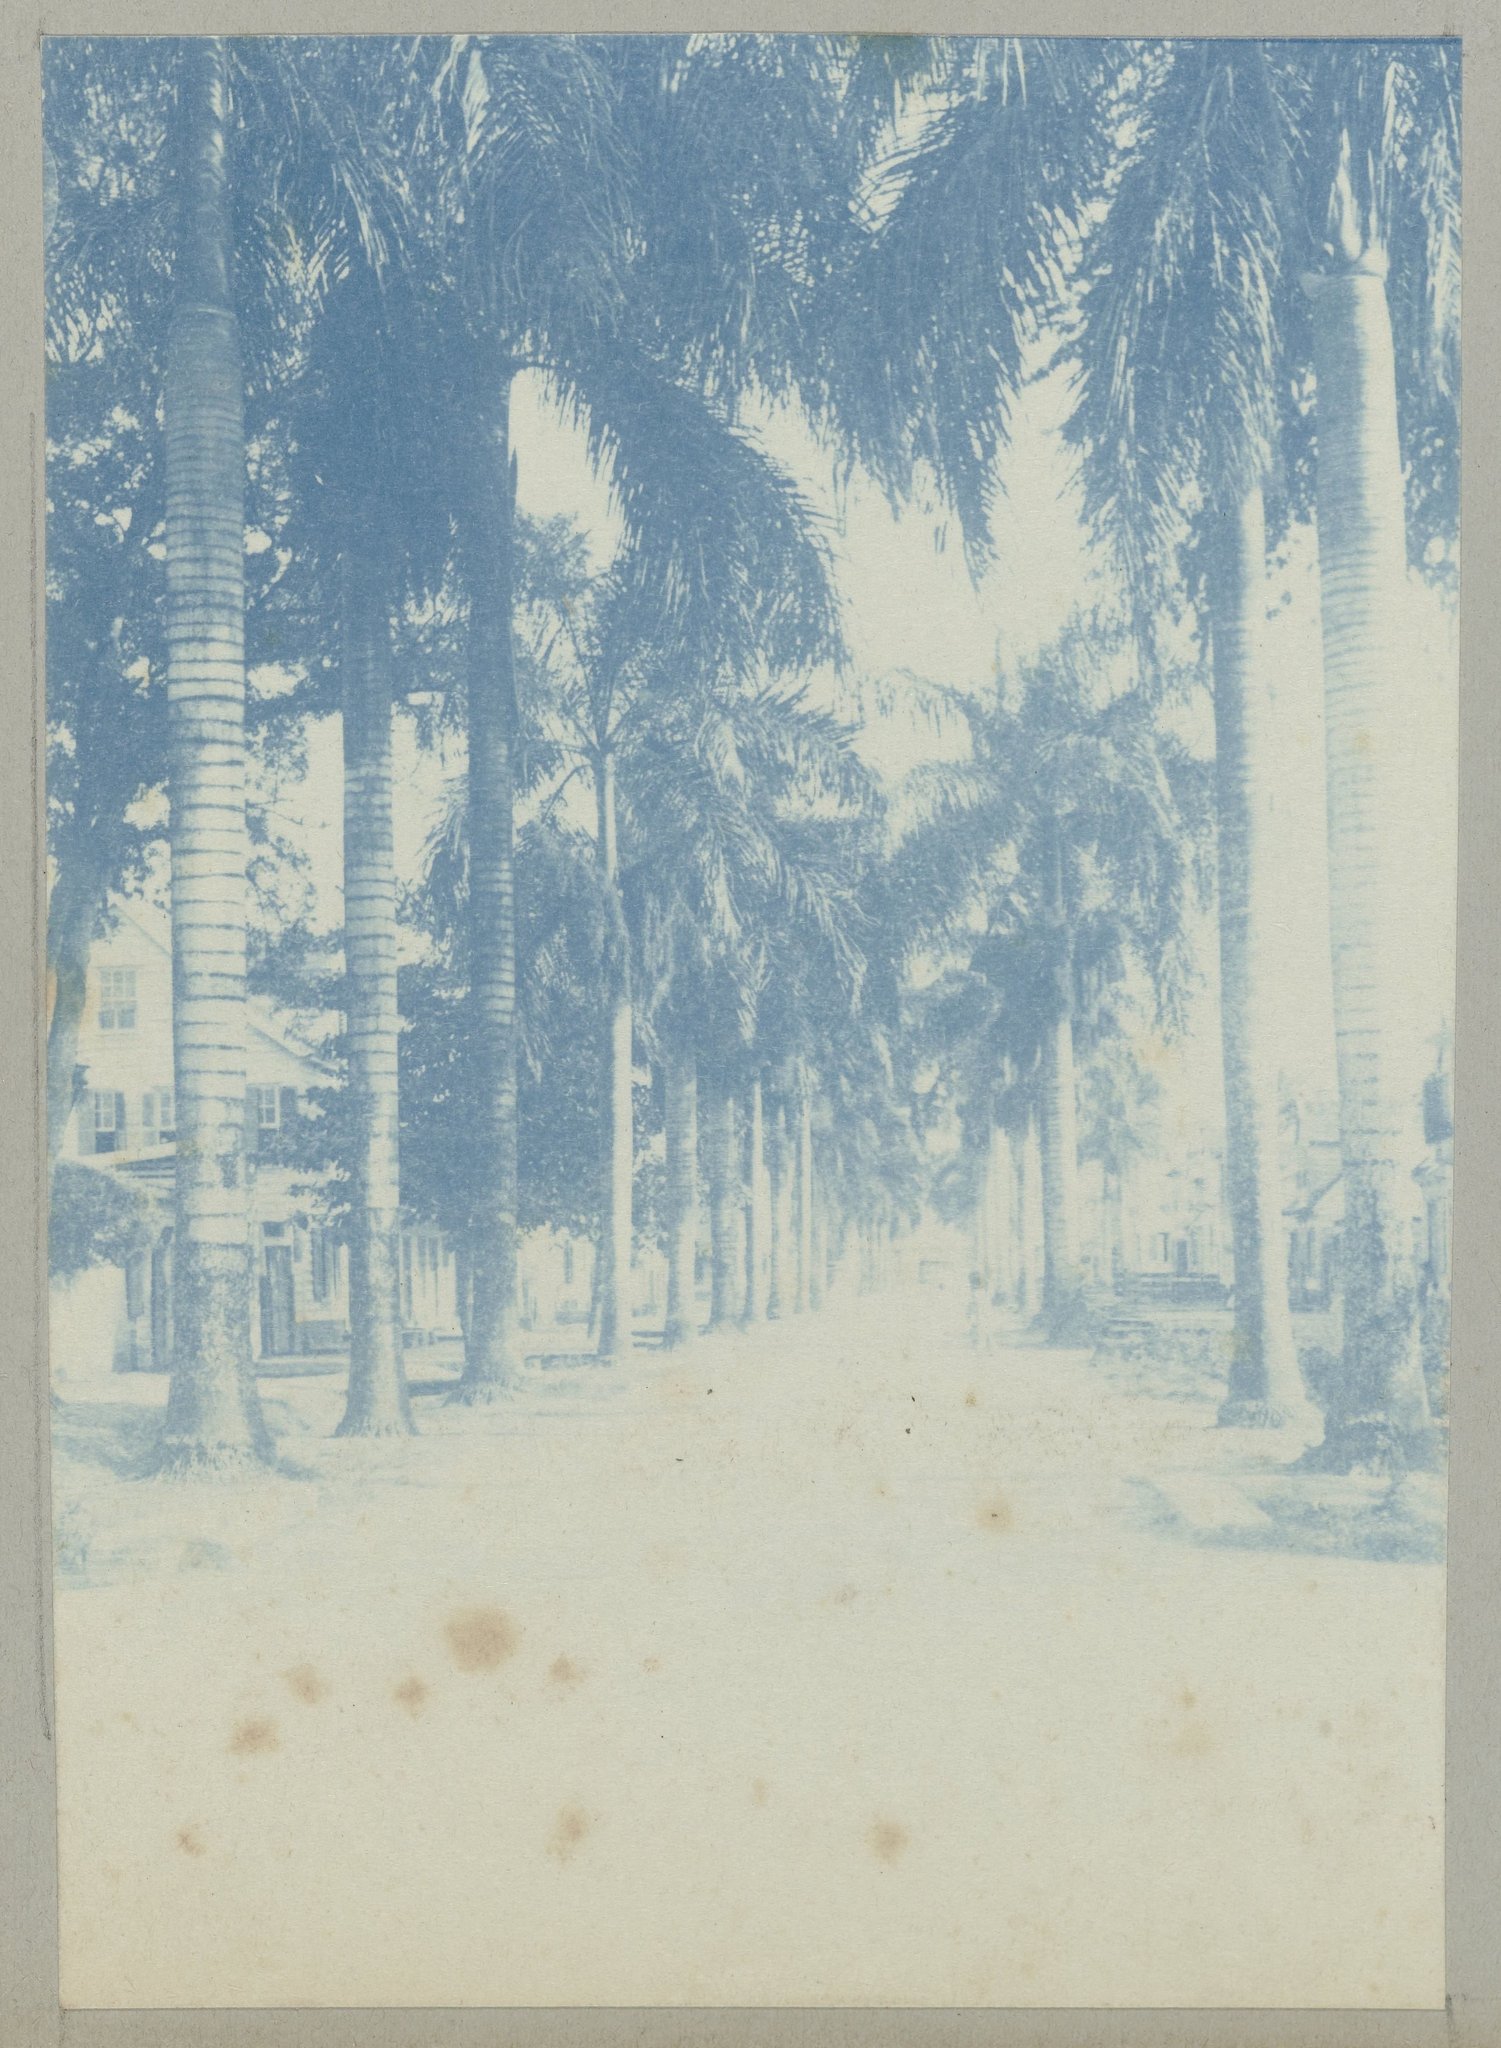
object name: photograph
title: Sommeldijksche straat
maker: hendrik doijer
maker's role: engineer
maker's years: 1863-1925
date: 1903-1910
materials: photographic support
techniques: cyanotype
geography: suriname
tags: suriname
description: Gezicht in de Sommelsdijkse straat te Paramaribo, aan weerszijden palmen. Onderdeel van het fotoalbum Souvenir de Voyage (deel 2), over het leven van de familie Doijer in en rond de plantage Ma Retraite in Suriname in de jaren 1903-1910.